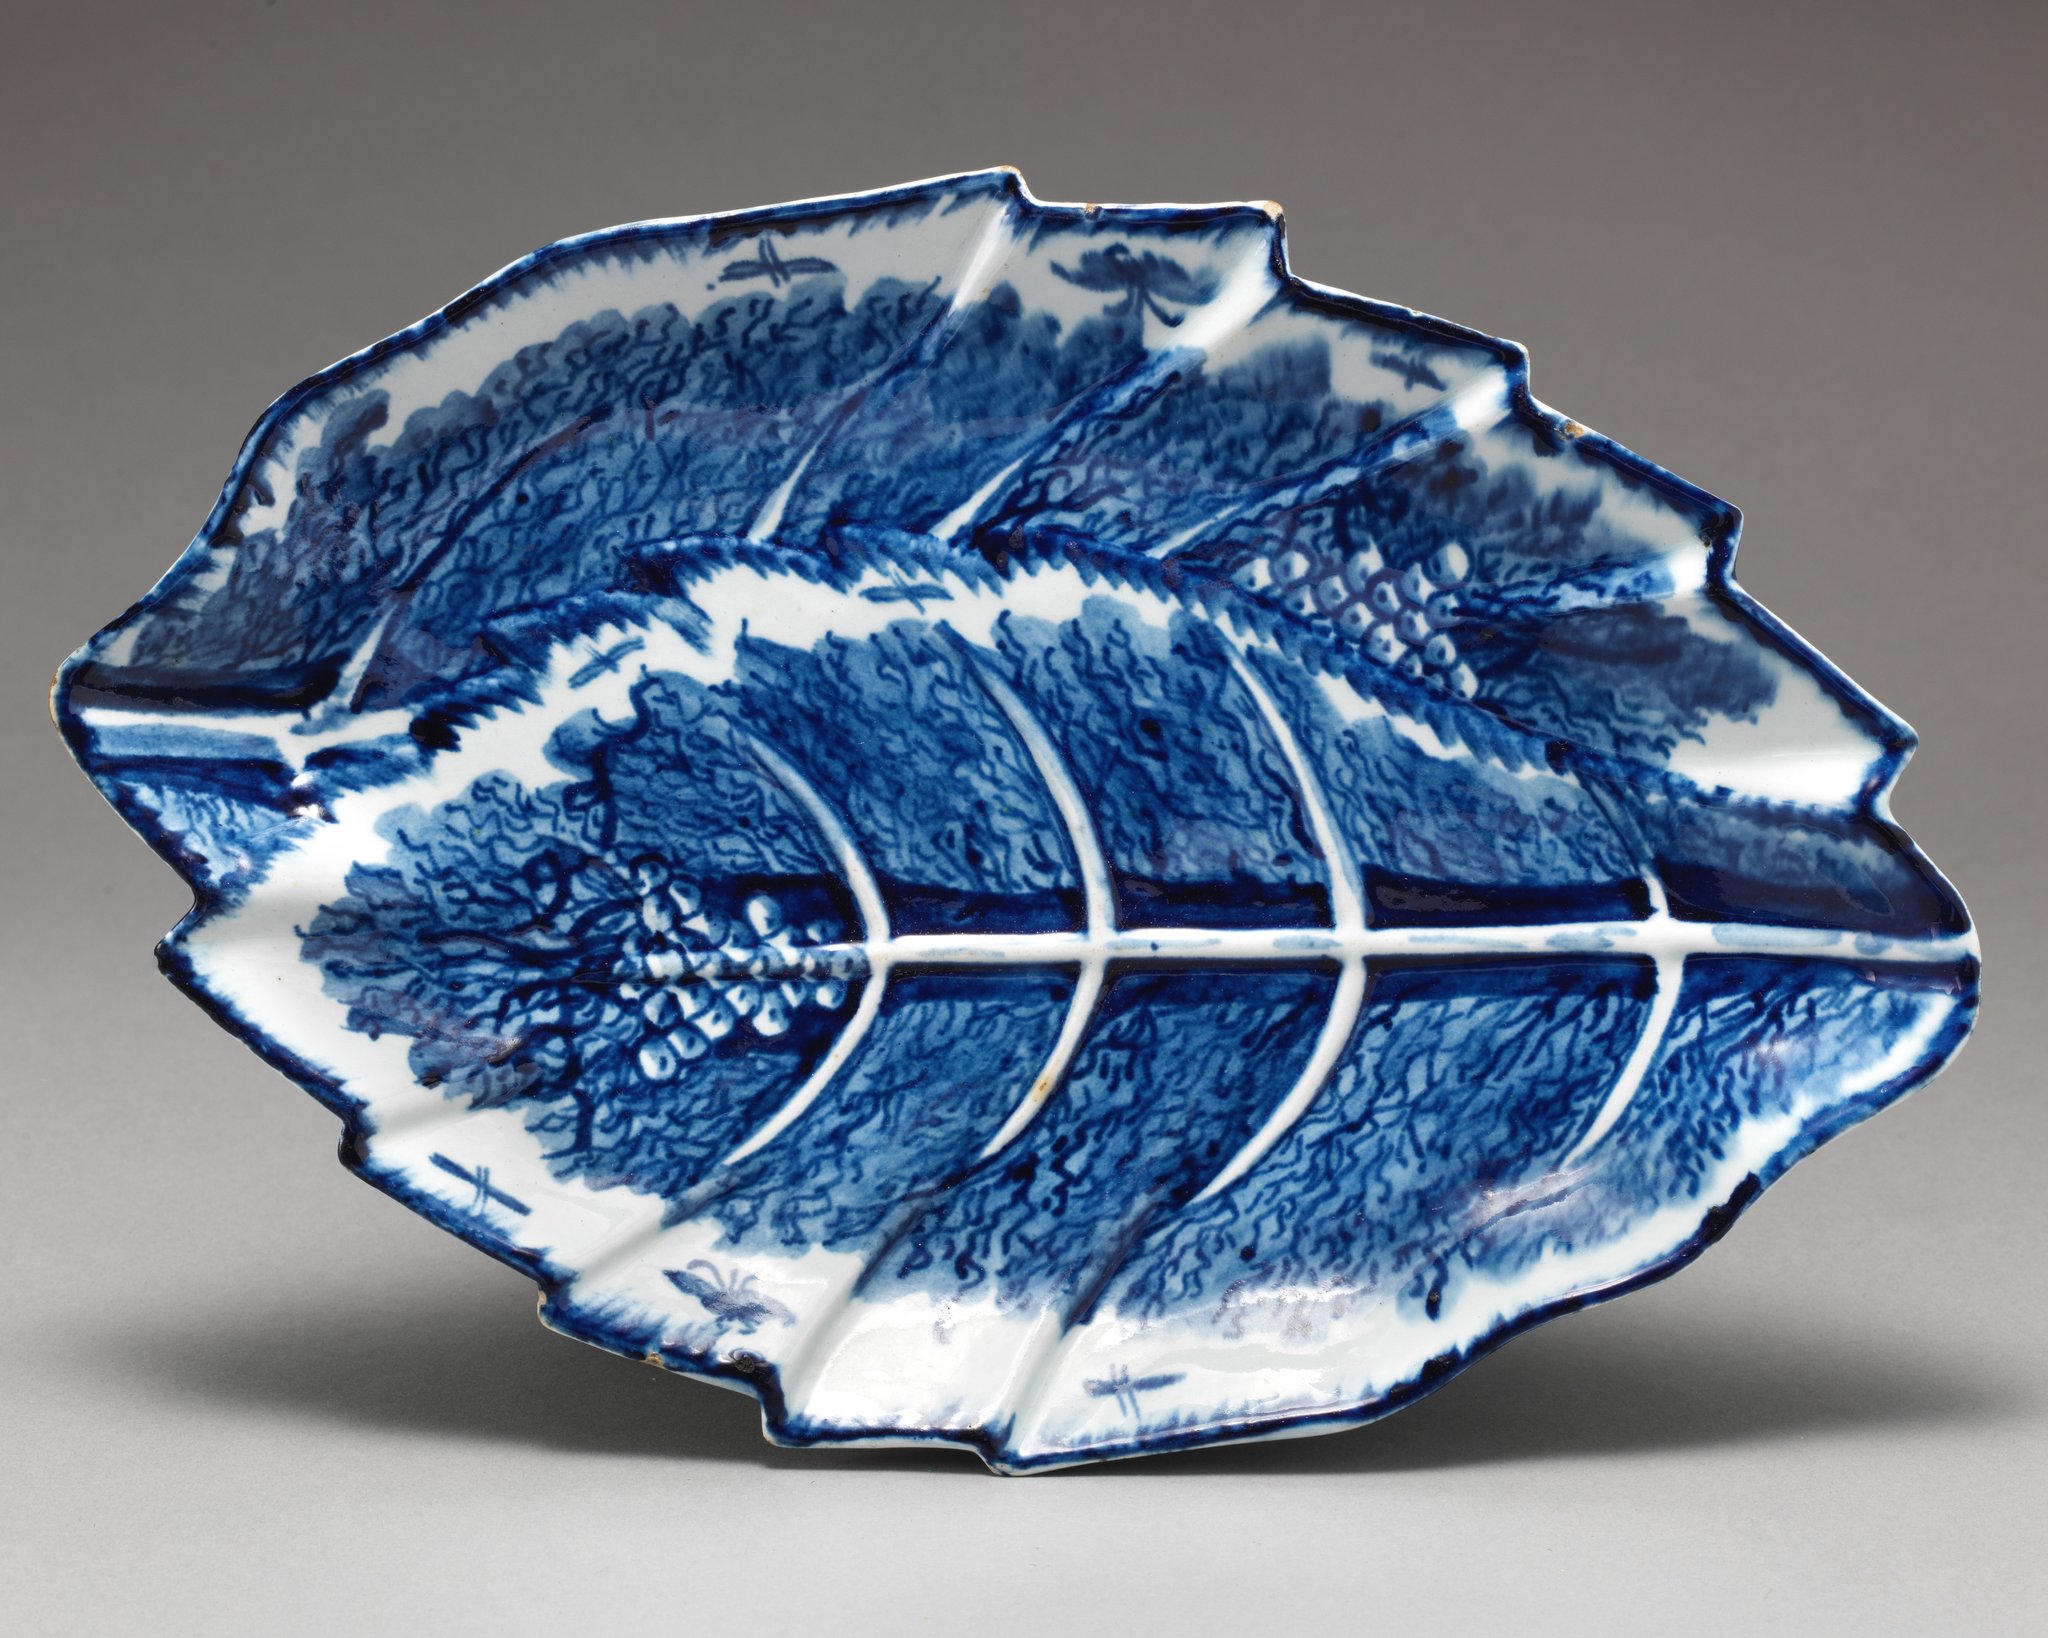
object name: dish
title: Dish (one of a pair)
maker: bow porcelain factory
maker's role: factory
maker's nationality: british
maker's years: 1747-1776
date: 1744-1783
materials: soft paste porcelain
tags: leaves